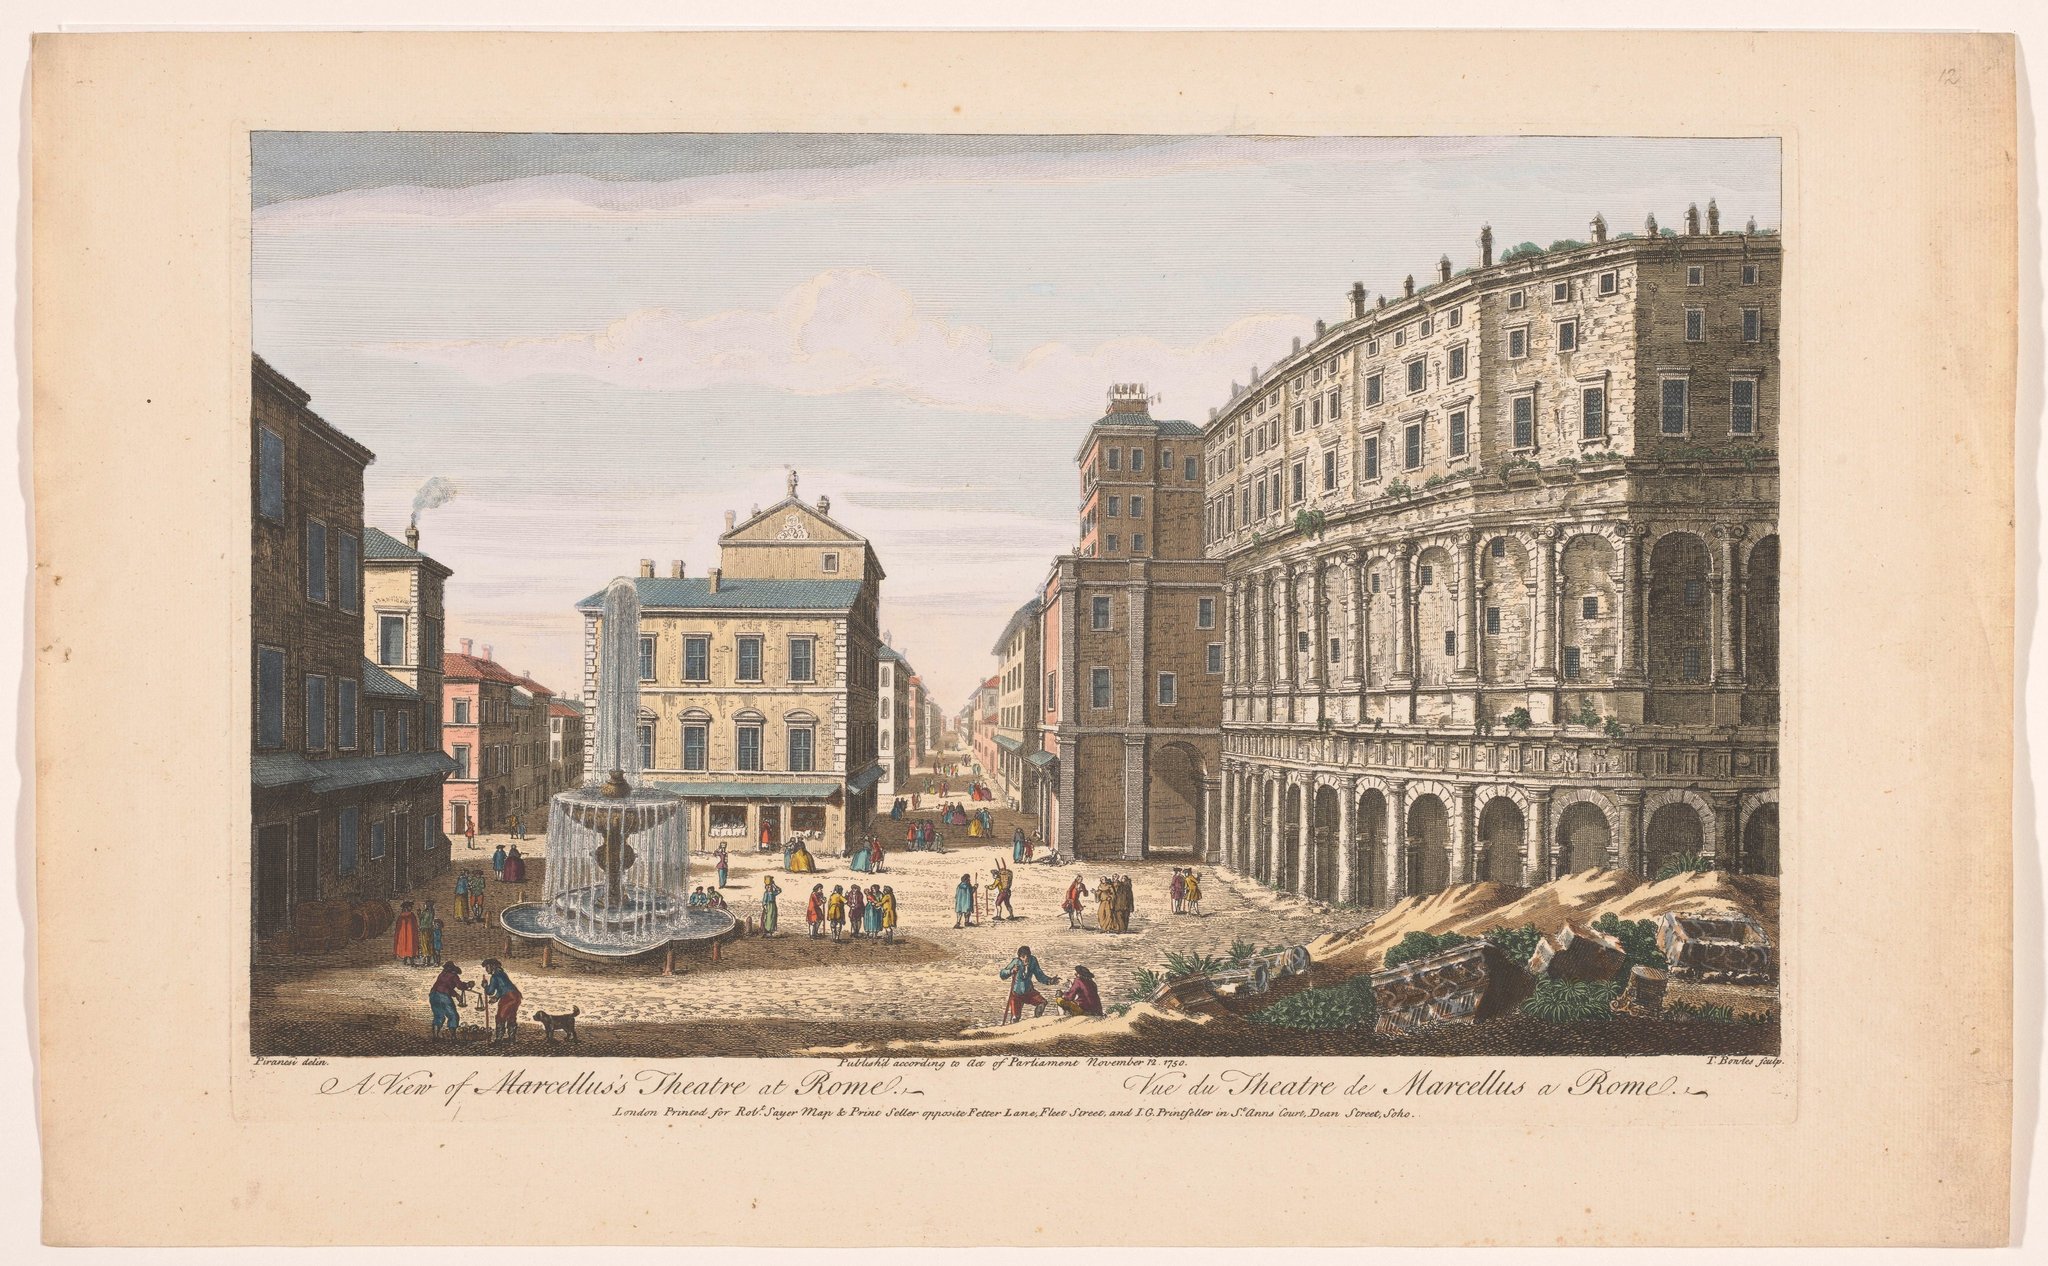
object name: opticaprent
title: Rome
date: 1750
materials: paper, watercolor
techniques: brush, etching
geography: london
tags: theatre (building), square, place, circus, etc. (+ city(-scape) with figures, staffage), ornamental fountain (+ city(-scape) with figures, staffage), street (+ city(-scape) with figures, staffage)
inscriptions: watermark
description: De serie “Rome” bevat twaalf prenten met de nummers 1-12, waarvan dit nummer 12 is.